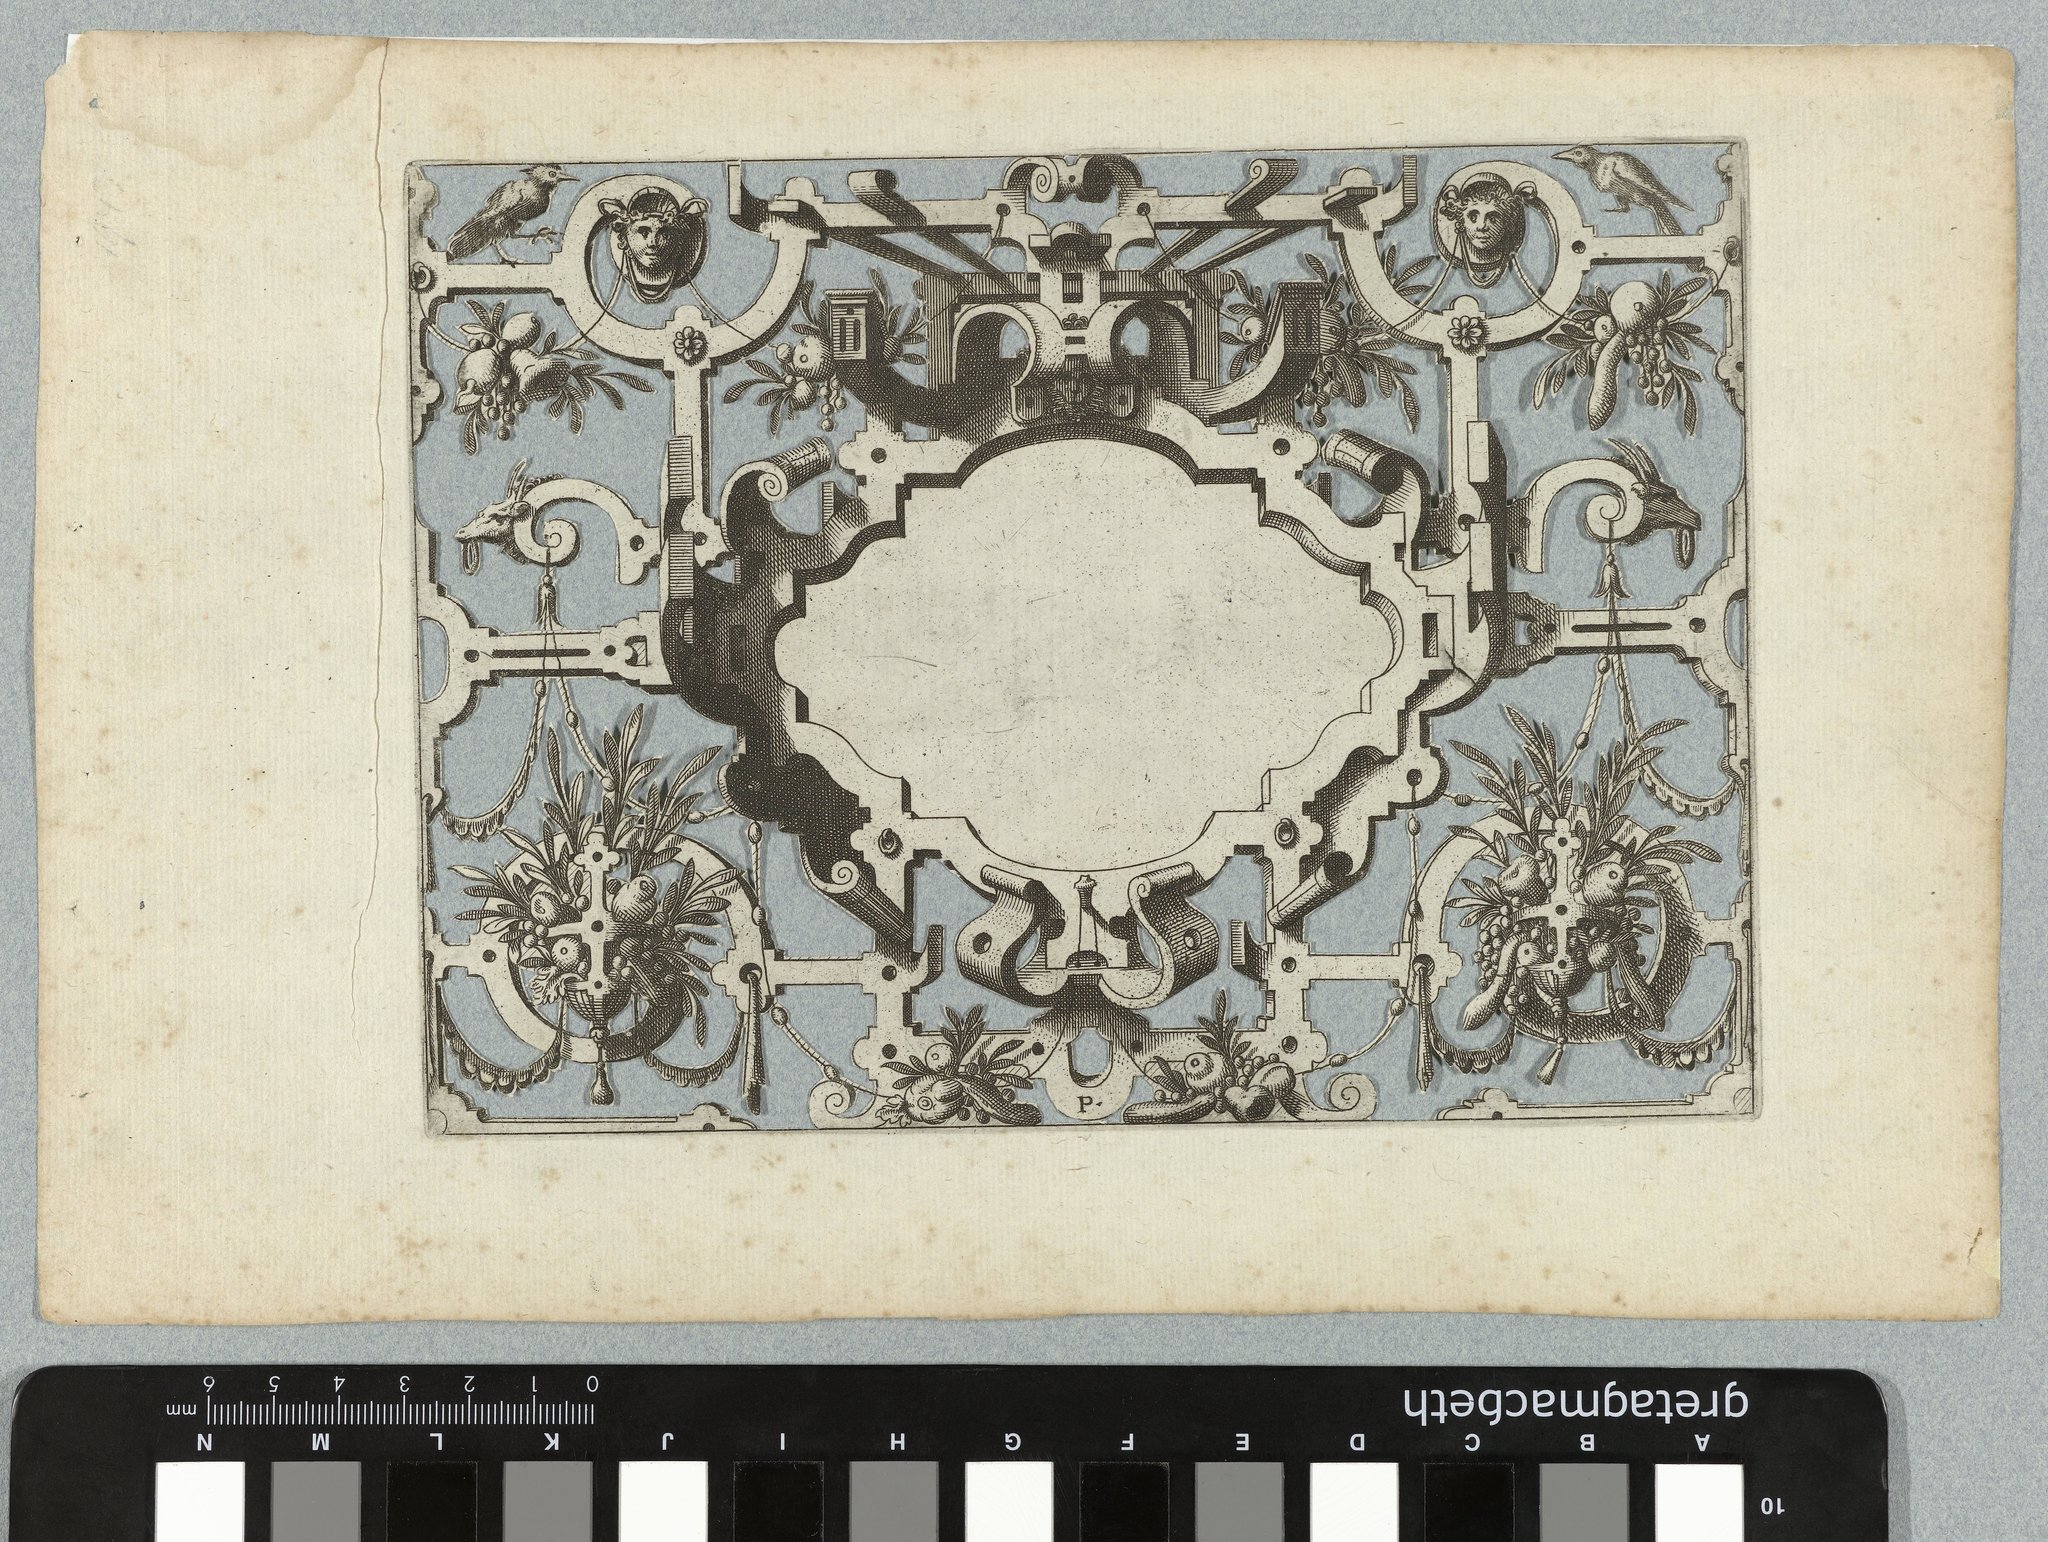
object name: print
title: Gesilhouetteerde ornamentprent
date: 1555-1560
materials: paper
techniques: engraving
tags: mask, mascaron ~ ornament, foliage, tendrils, branches ~ ornament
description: Blad P uit serie van 16 bladen, geletterd A-Q. Gesilhouetteerde ornamentprent: alle niet figuratieve partijen zijn weggesneden. Cartouche gedecoreerd met guirlandes en vruchtentrossen. Bovenaan twee vogels en twee mascarons.